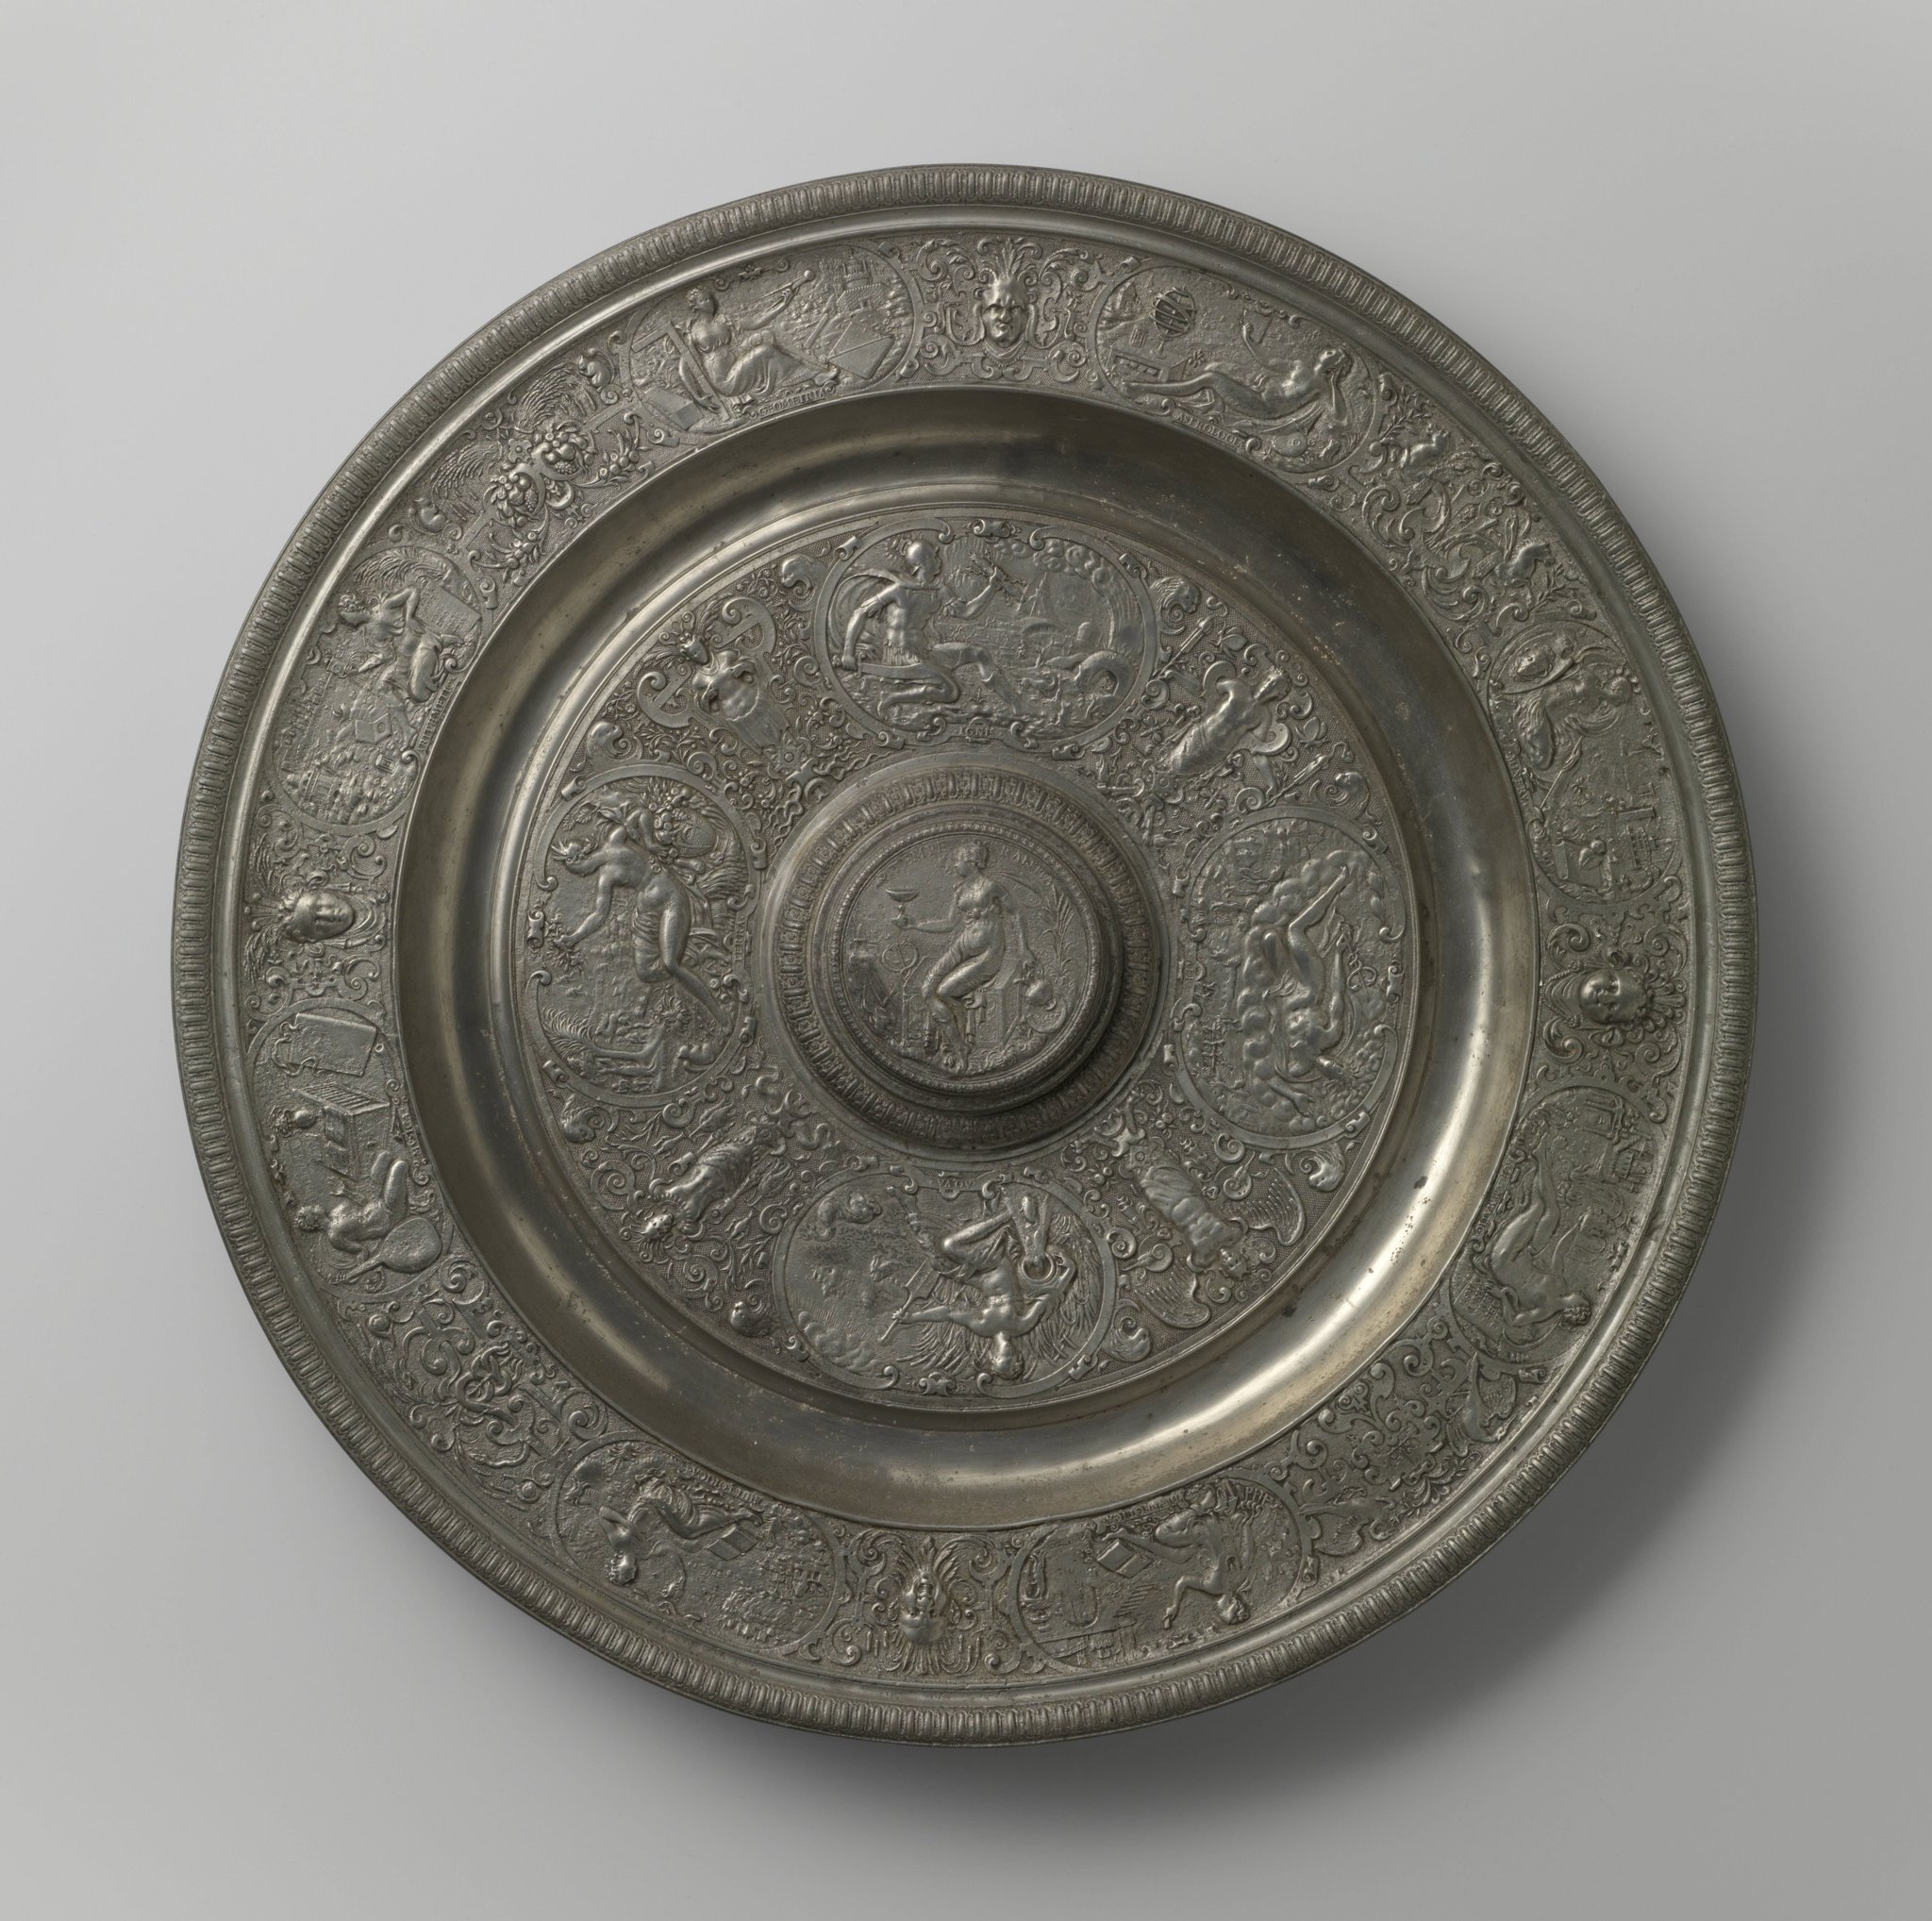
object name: platter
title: Temperantia-schotel van tin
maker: françois briot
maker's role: pewterers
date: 1585-1590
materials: tin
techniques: casting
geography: france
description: Temperatia-schotel van tin. Het plat heeft in een het midden een verhoging met daarop een voorstelling van de matigheid. Op het lage deel van het plat zijn in ovalen, gescheiden door hermen in rolwerk, de vier elementen afgebeeld. Met de klok mee: vuur, lucht, water en aarde. De opgang van plat naar rand is ongedecoreerd. De rand is gedecoreerd met in ovalen, gescheiden door grotesken in rolwerk, de zeven vrije kunsten en Minerva. Met de klok mee: Astrologia, Minerva, Grammatica, Dialectica, Rhetorica, Musica, Arithmetica en Geometria. Op de onderzijde is in het midden een medaillonportret van François Briot aangebracht.